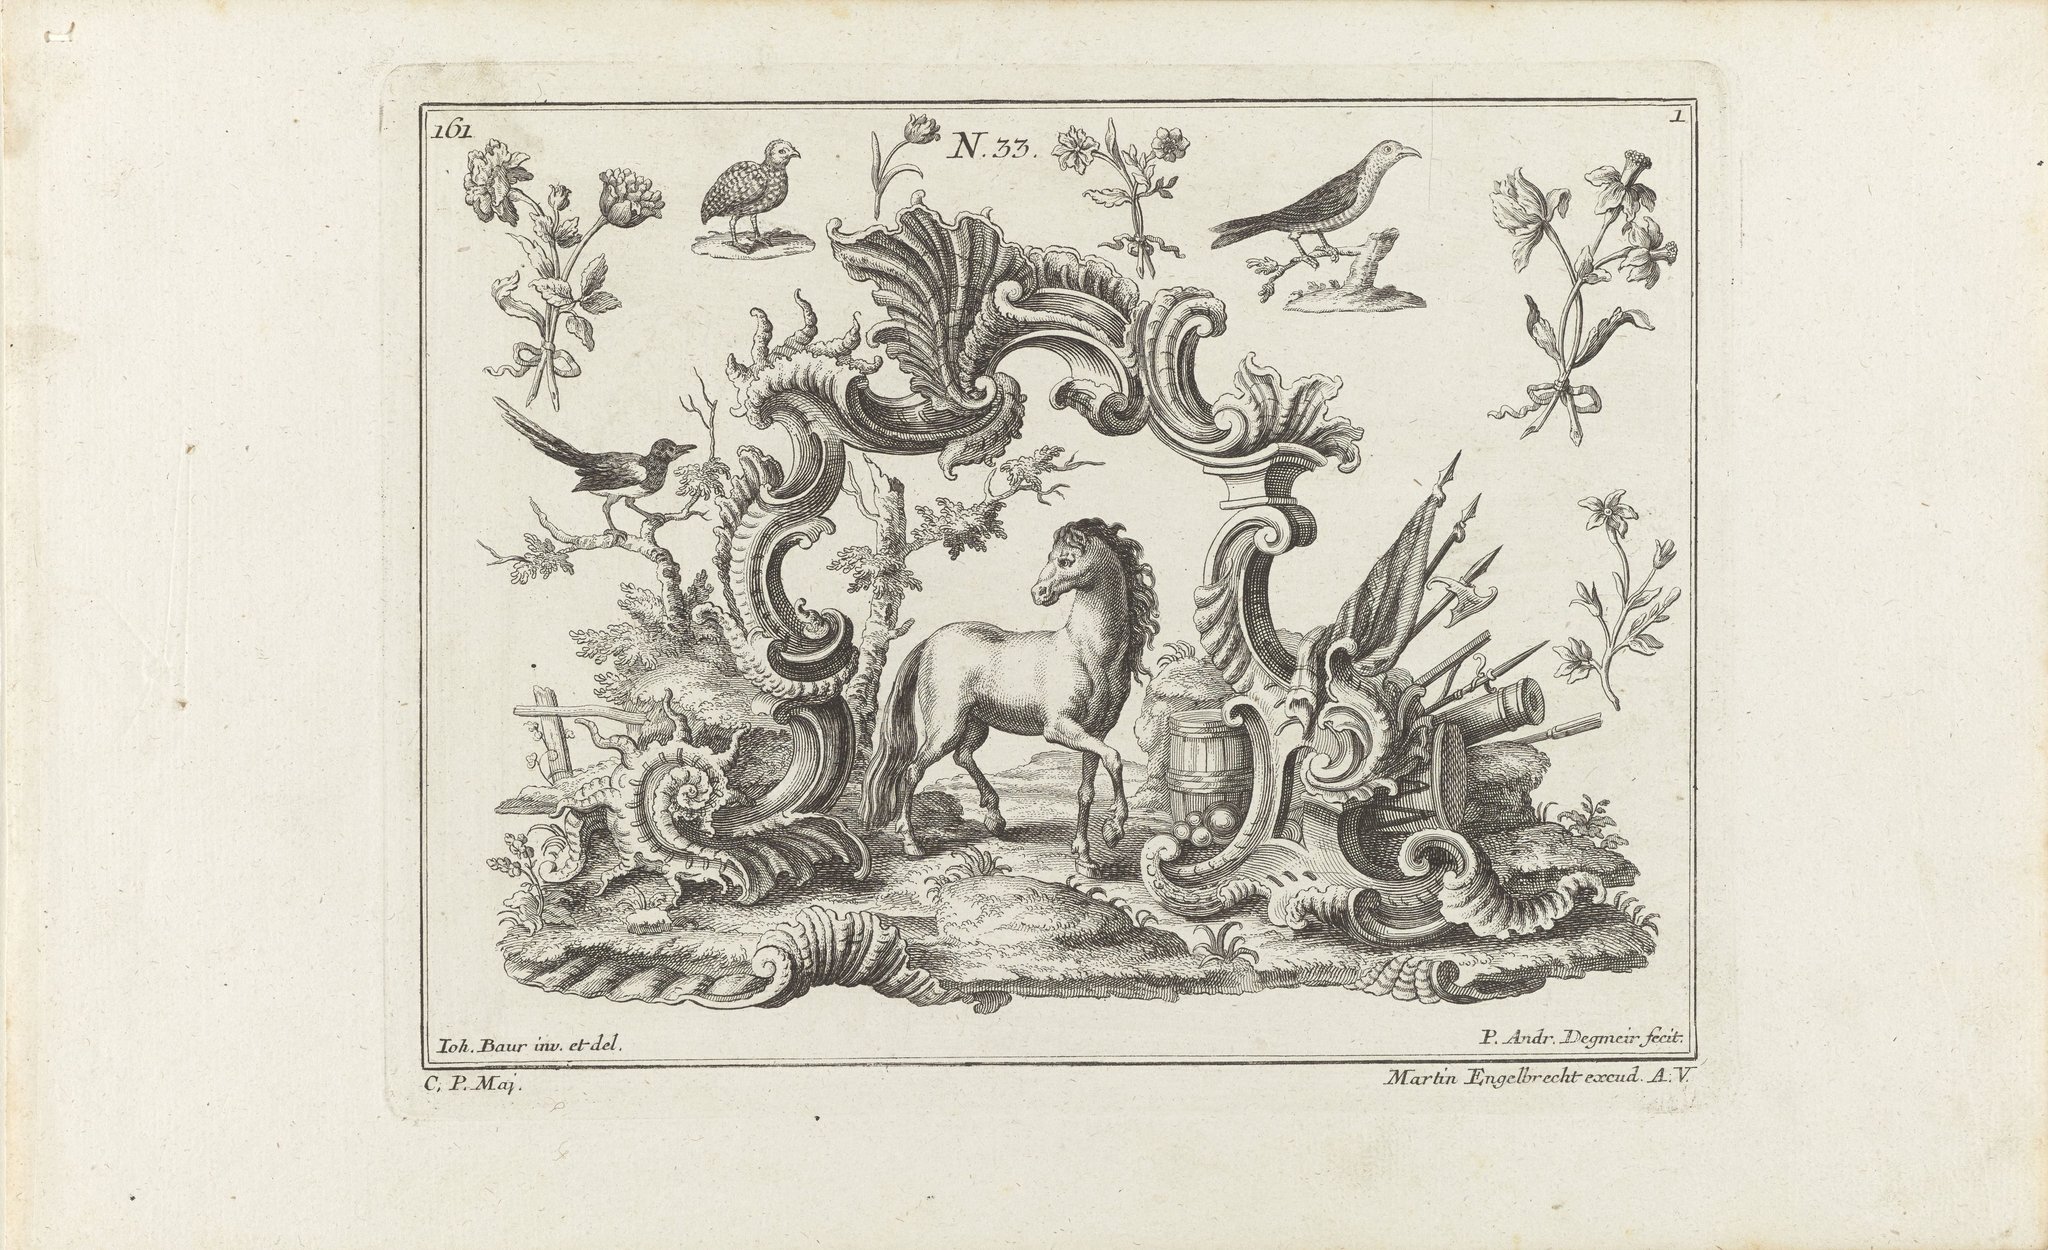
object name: ornament print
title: De vier werelddelen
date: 1719-1749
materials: paper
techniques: etching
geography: augsburg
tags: flowers, rocaille ornament, europe represented allegorically; 'europa' (ripa), birds, weapons, horse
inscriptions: collector's mark: Lugt 2228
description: Het paard staat onder een boog van rocailles. Ernaast kanonskogels en een ton, mogelijk een kruitvat. De boog wordt omgeven door verschillende vogels, bloemen en wapens. Midden boven 33 en linksboven 161 genummerd.